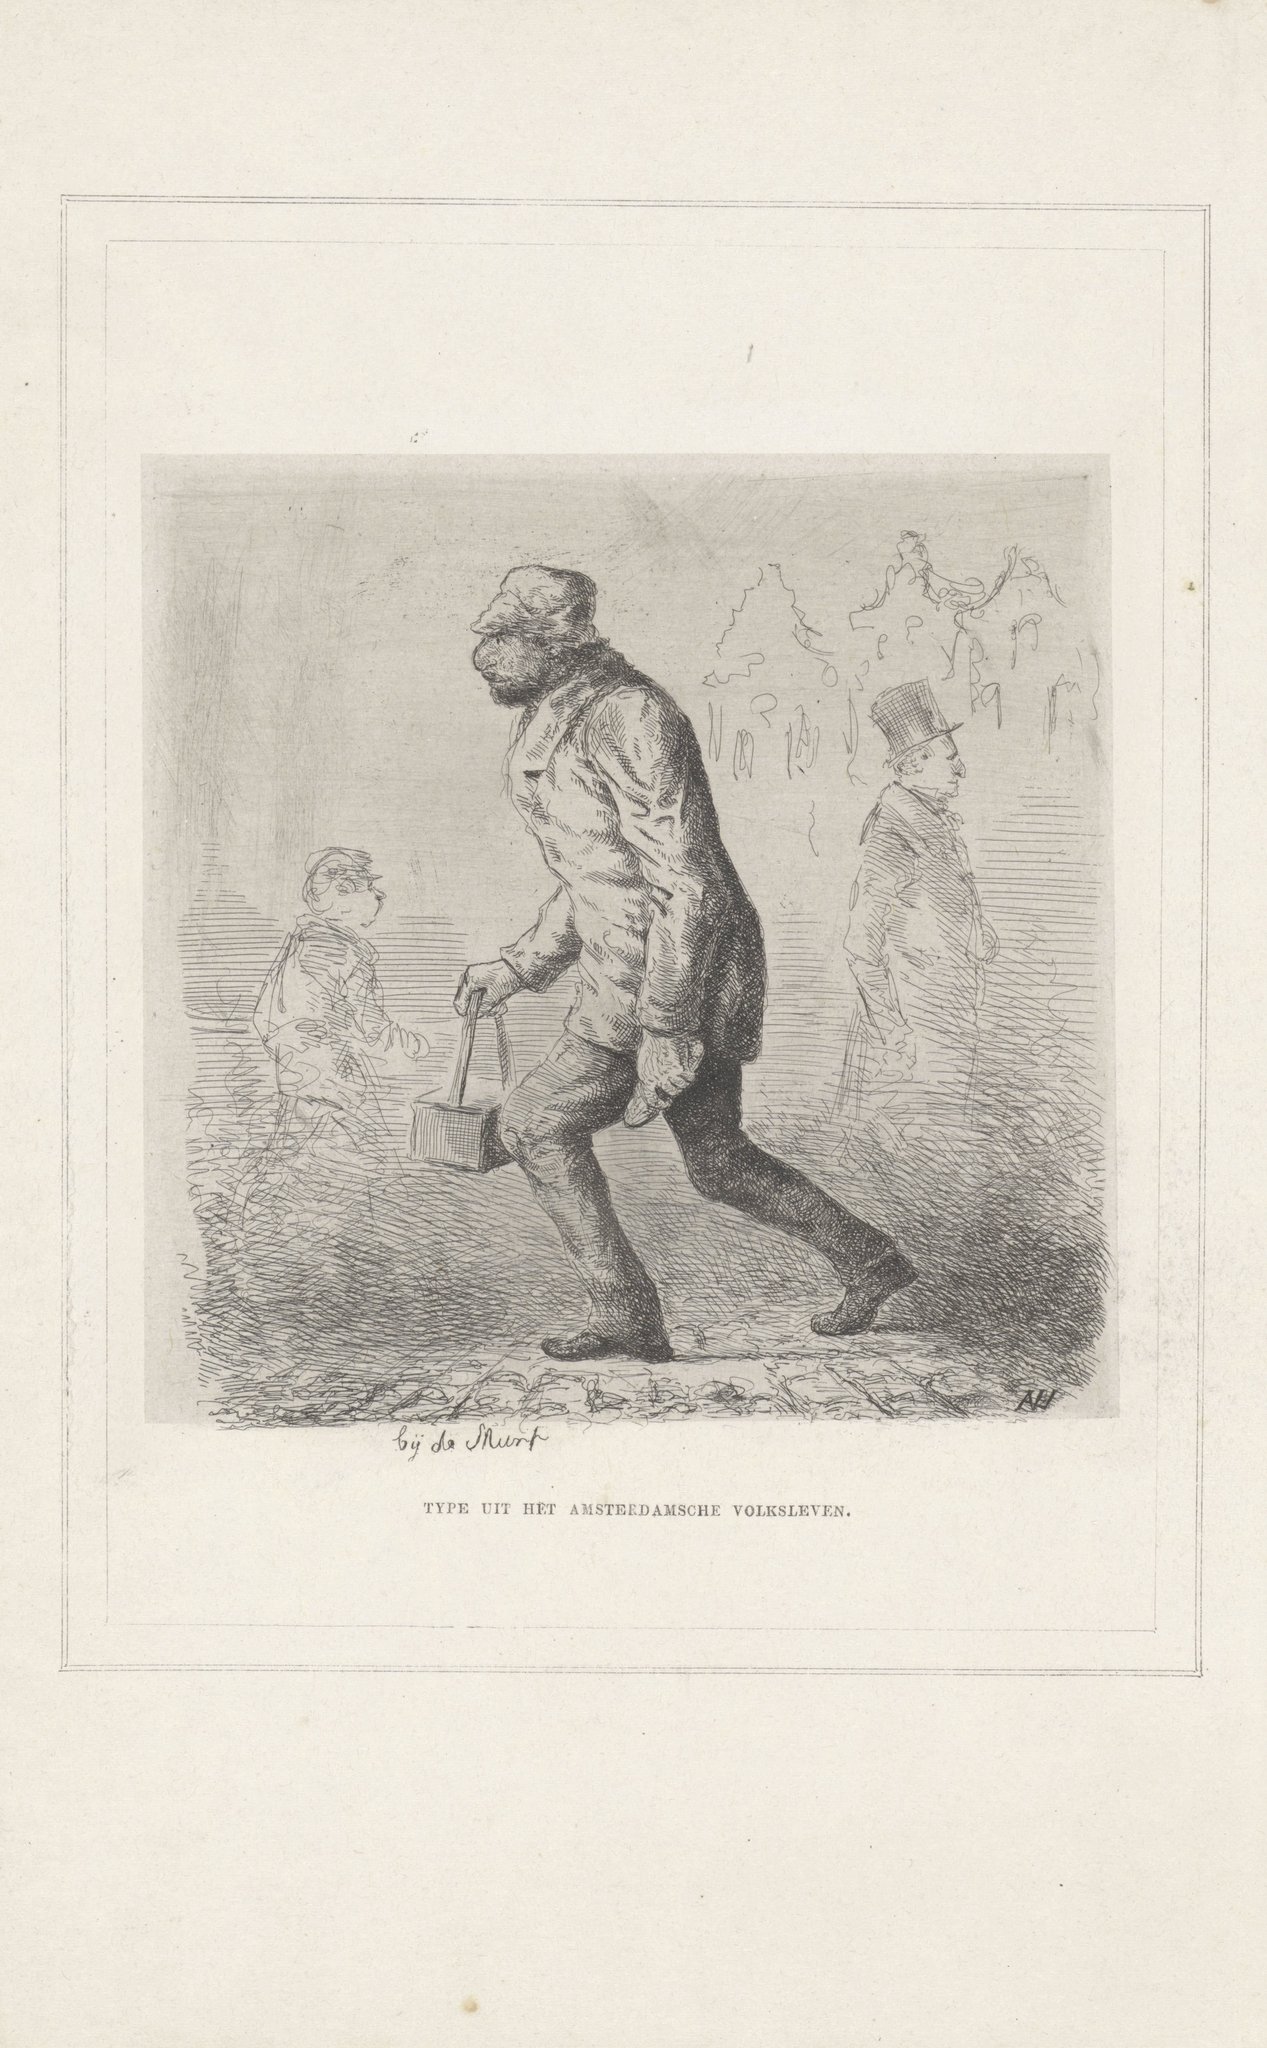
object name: print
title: bij de Munt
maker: alexander ver huell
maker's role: draughtsman, print maker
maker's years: 1822-1897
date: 1832-1879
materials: paper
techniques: etching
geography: netherlands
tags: walking (+ left side visible; left - (l. hand, l. foot, etc.)), accessories ~ shoes, e.g. insole, shoehorn, shoe-polish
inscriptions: collector's mark: Lugt 2228